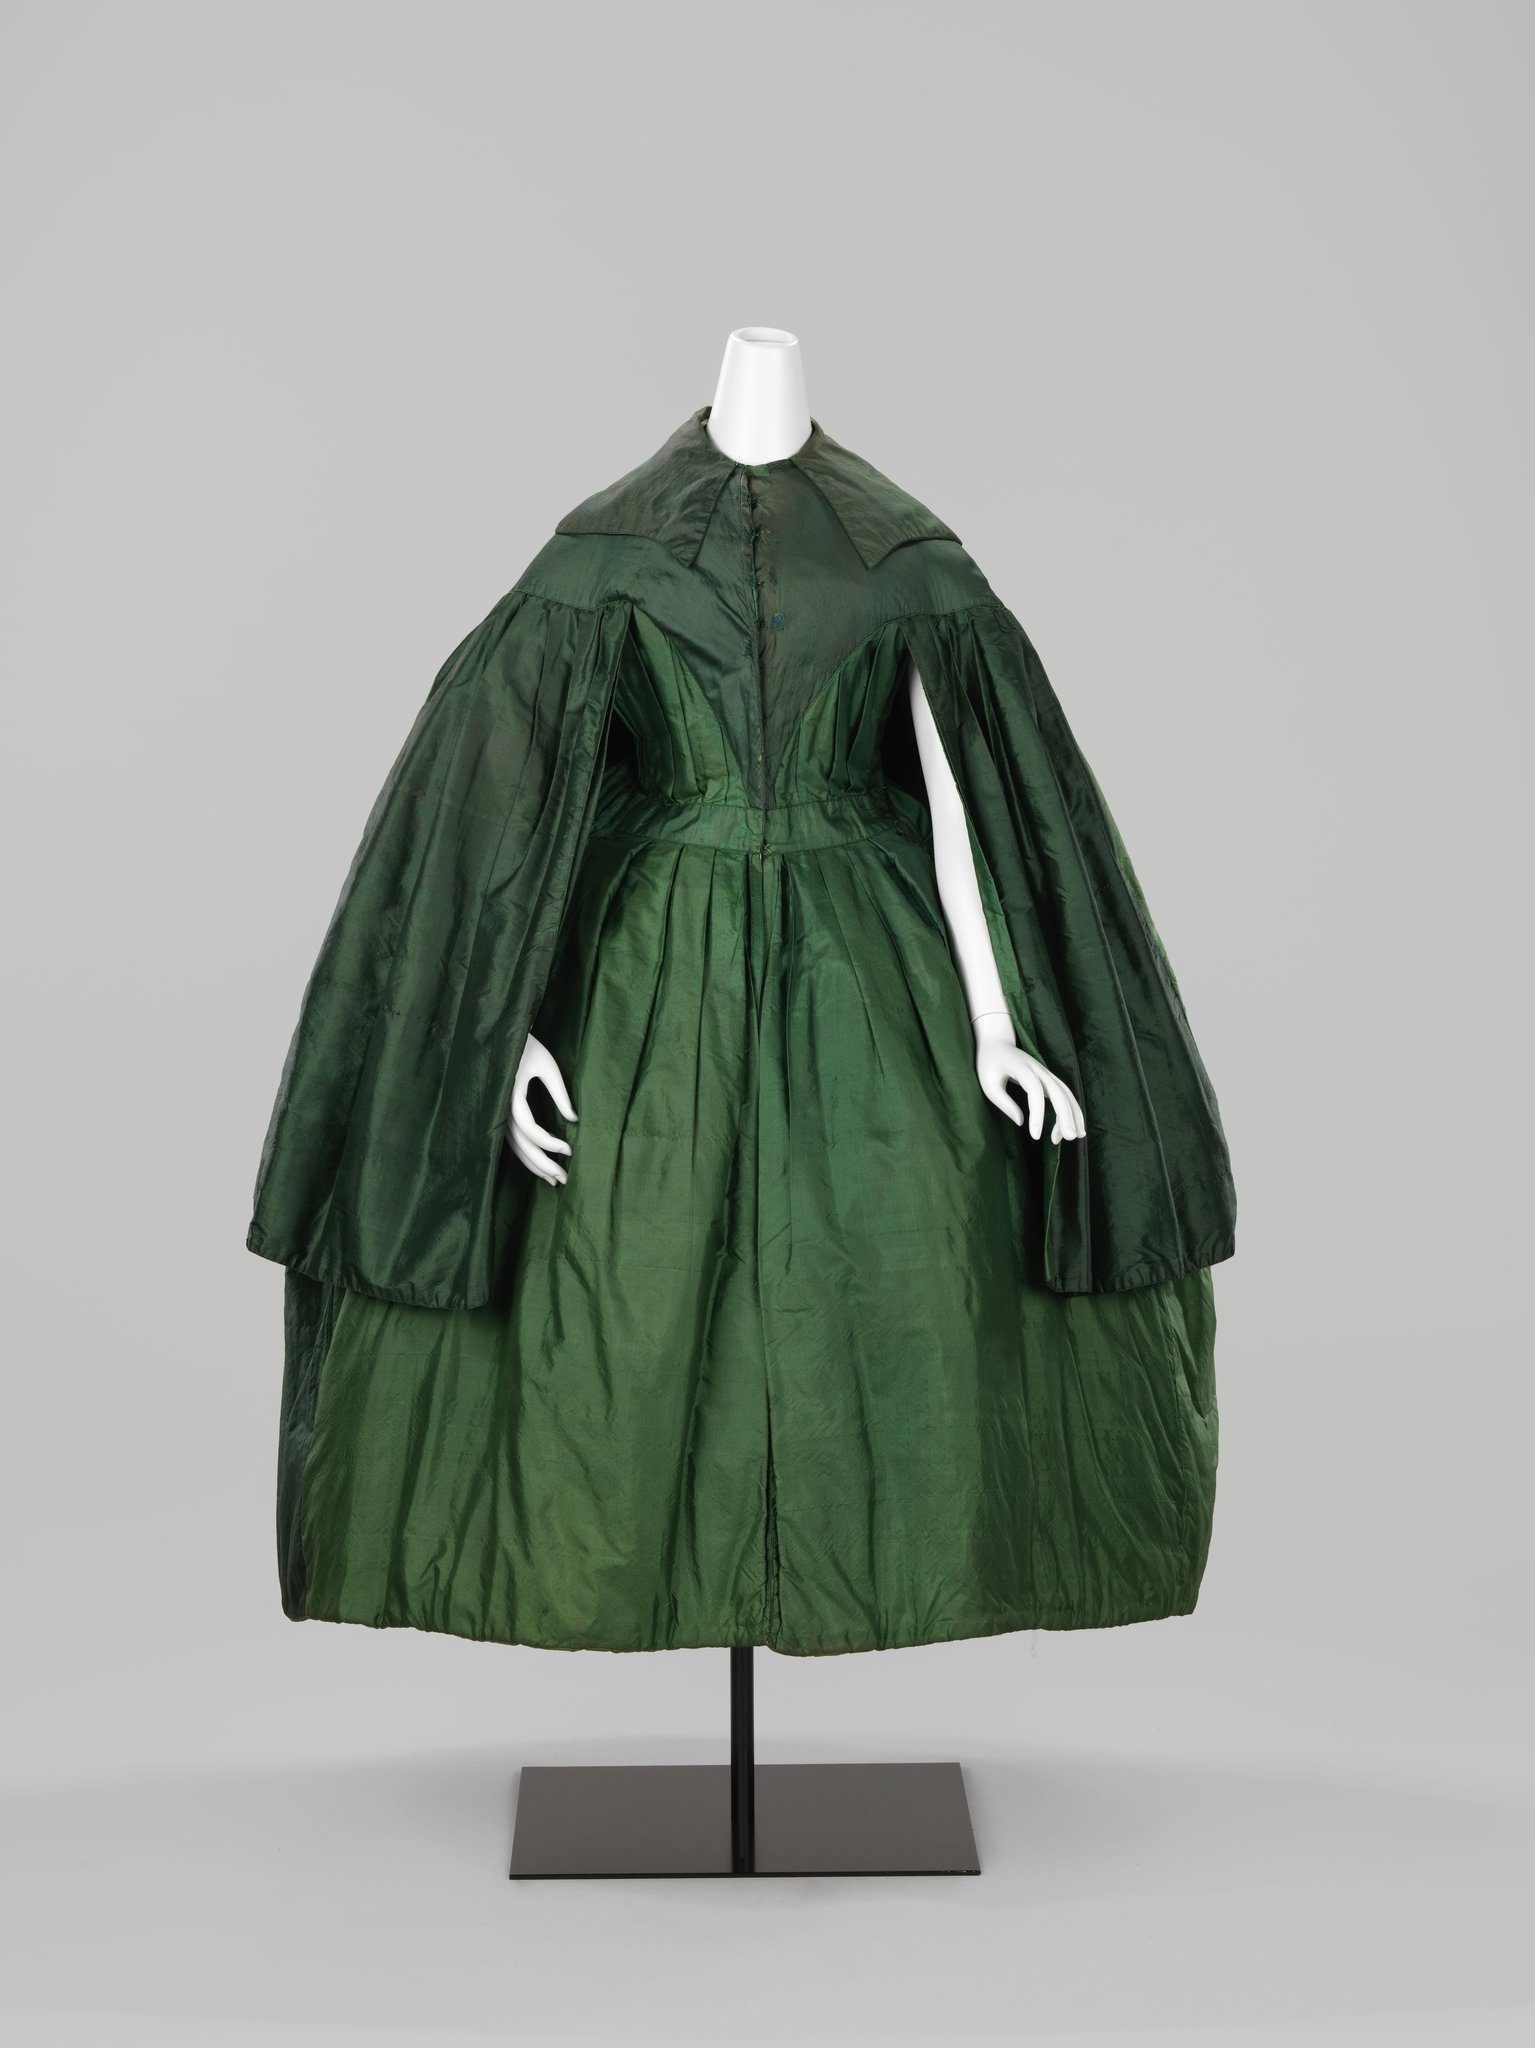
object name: cloak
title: Cape of 'douillette' met liggende kraag en pelerine van twee lagen tafzijde van groene gewatteerde tafzijde, met een blauwe zijde voering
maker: Anonymous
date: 1830-1840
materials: silk, textile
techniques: padding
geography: netherlands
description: Cape of mantel, bekend als `Douillette', van flesgroene tafzijde. Driekwart lang, wijd model, gewatteerd en met pelerine. In plate plooien en met armsplitten zijn de banen aan een glad aflopend schouderstuk met puntige voorpanden, gezet. Hieraan is een halflange pelerine van twee lagen tafzijde meegenaaid. Brede liggende kraag. Voering vaqn marineblauwe zijde. Onderaan een 18de eeuws groen boorlint.